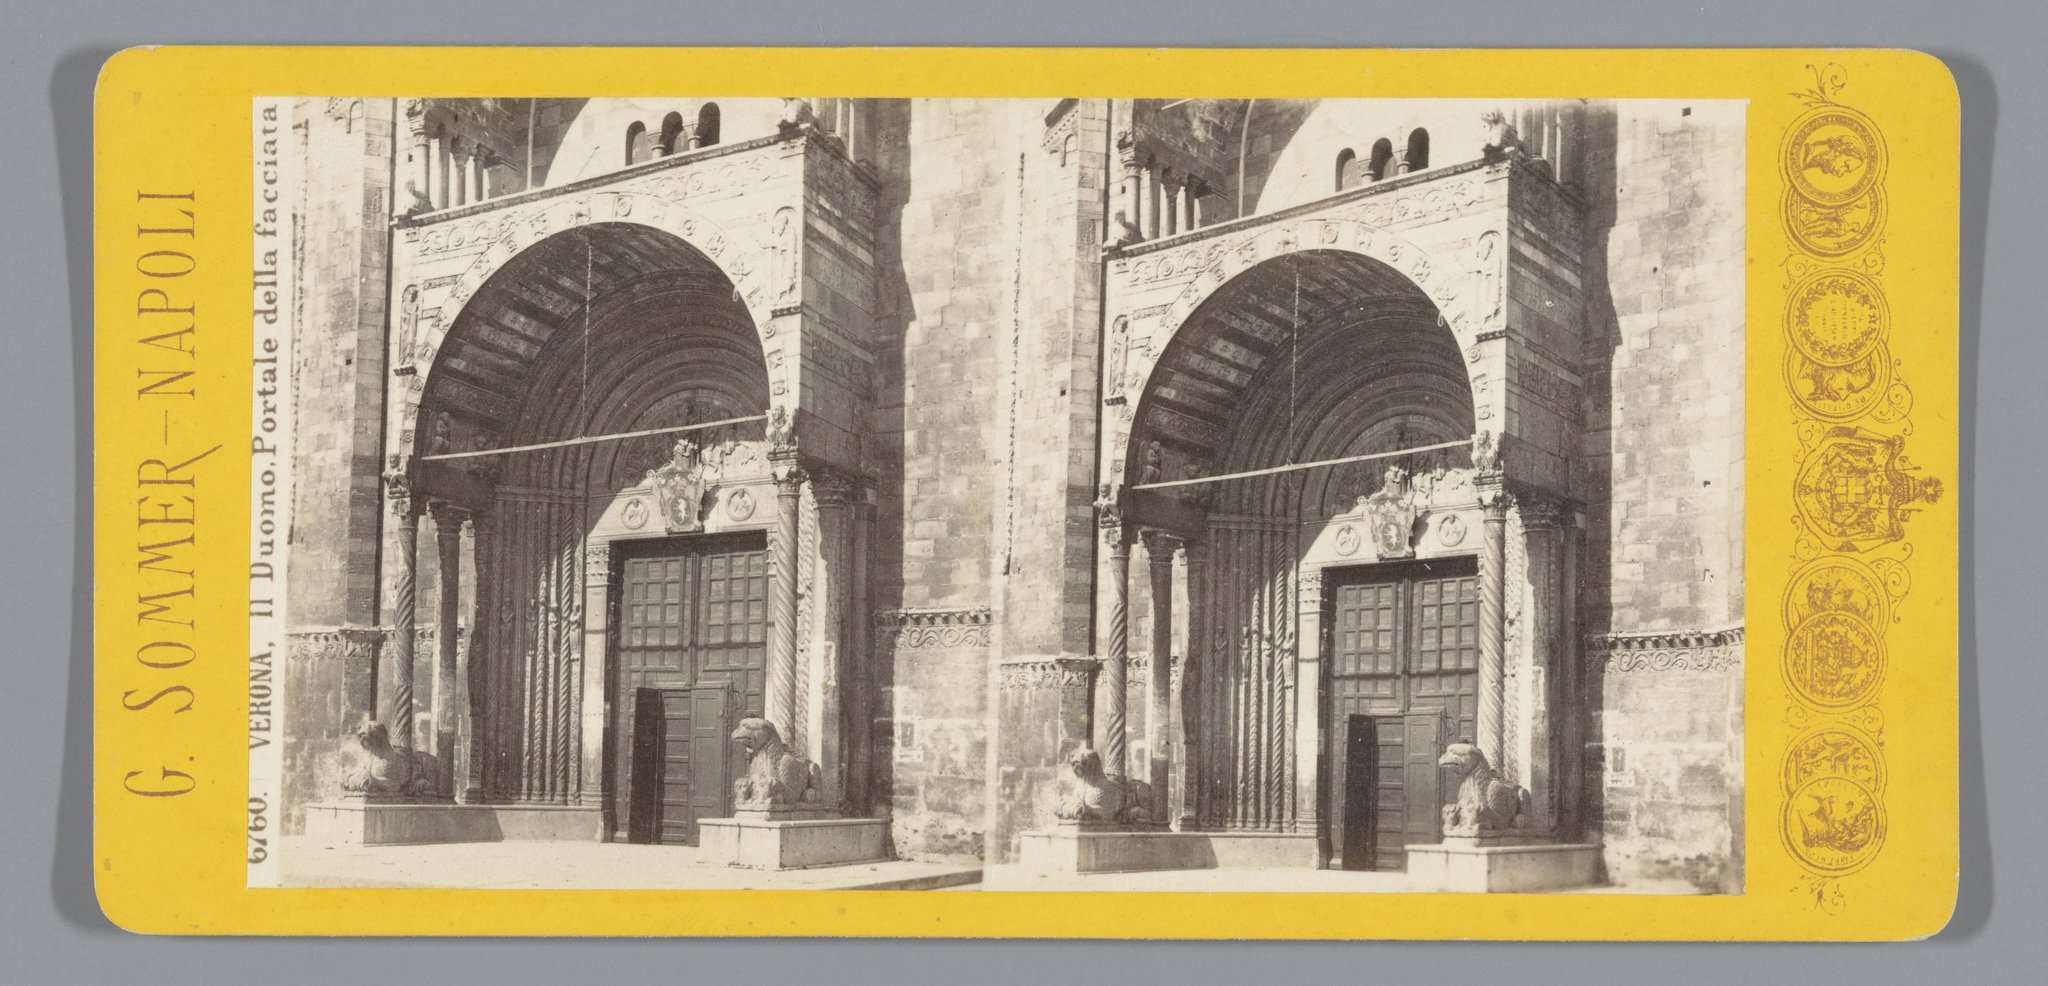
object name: stereograph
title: Gezicht op het portaal van de Dom van Verona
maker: giorgio sommer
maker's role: fotograaf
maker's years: 1834-1914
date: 1860-1880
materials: cardboard, photographic support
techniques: albumen print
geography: verona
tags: parts of church exterior and annexes: portal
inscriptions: number: ‘6760’